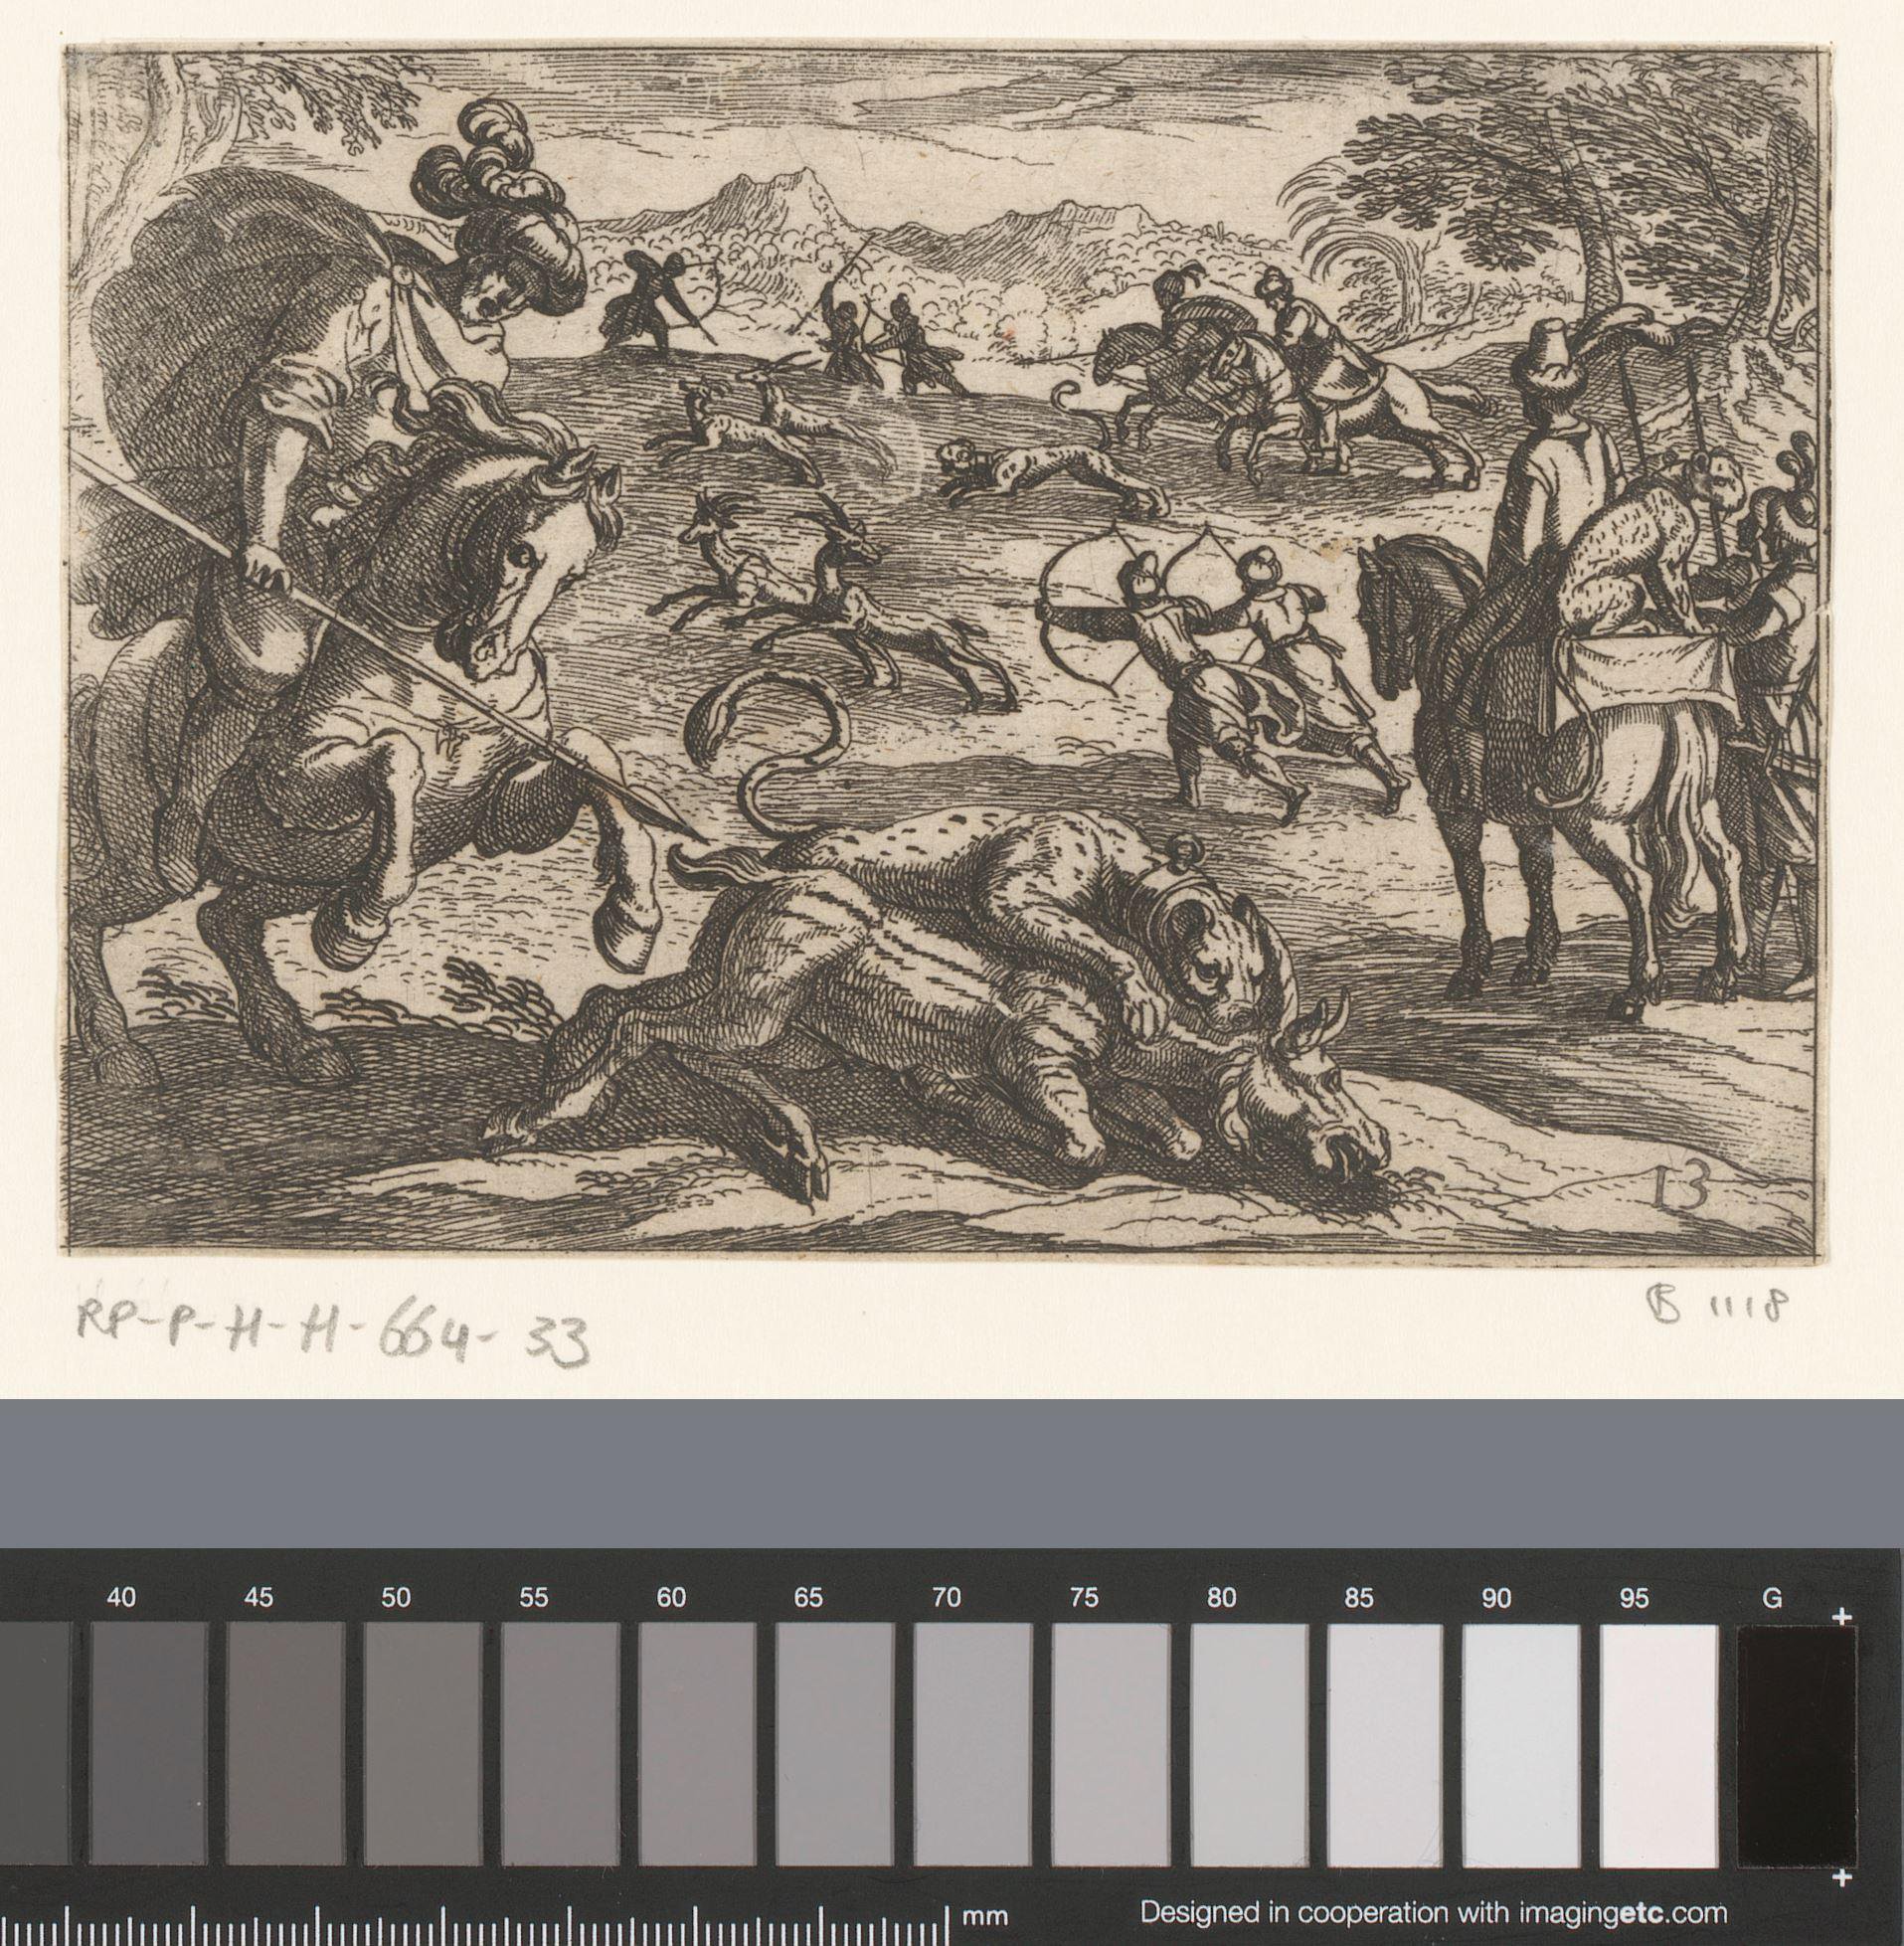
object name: print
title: Jacht op herten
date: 1598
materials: paper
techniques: etching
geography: vatican city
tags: beasts of prey, predatory animals: leopard, stag-hunting, hunter, hunters hunting (n.b.: in 1988-1990 this notation denoted the concept of 43c11421 'hunters resting during the hunt')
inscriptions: collector's mark: ‘Hinloopen’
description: Deze prent maakt deel uit van een reeks van vijftien prenten met jachtscènes (+ opdracht).